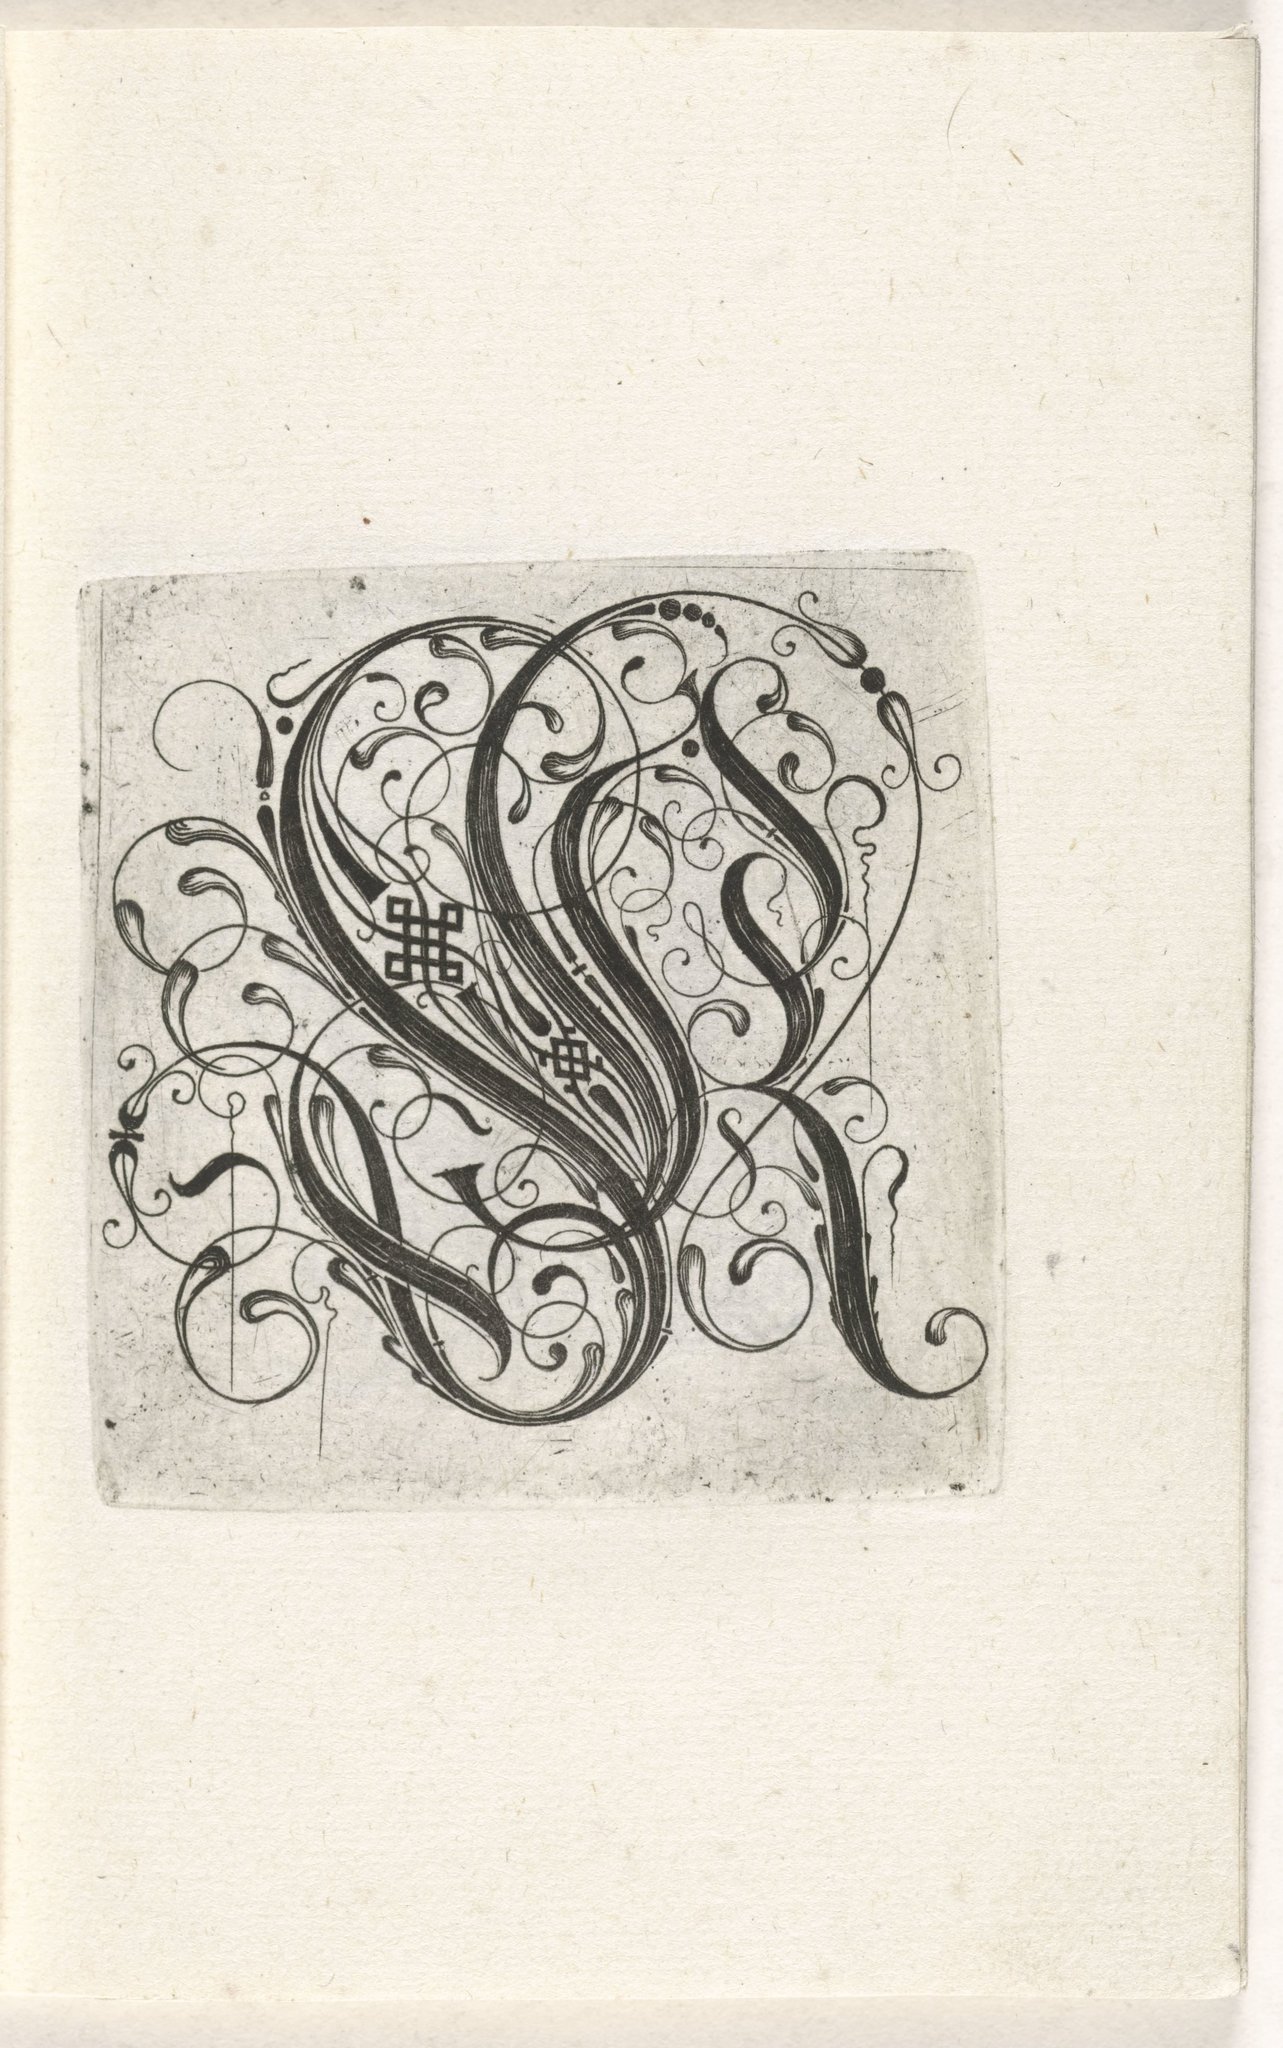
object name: ornament print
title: Letter K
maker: Anonymous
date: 1600-1699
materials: paper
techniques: engraving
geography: netherlands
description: Uit serie van 24 gotische letters met vlechtwerk: A-I, K-T en V-Z.